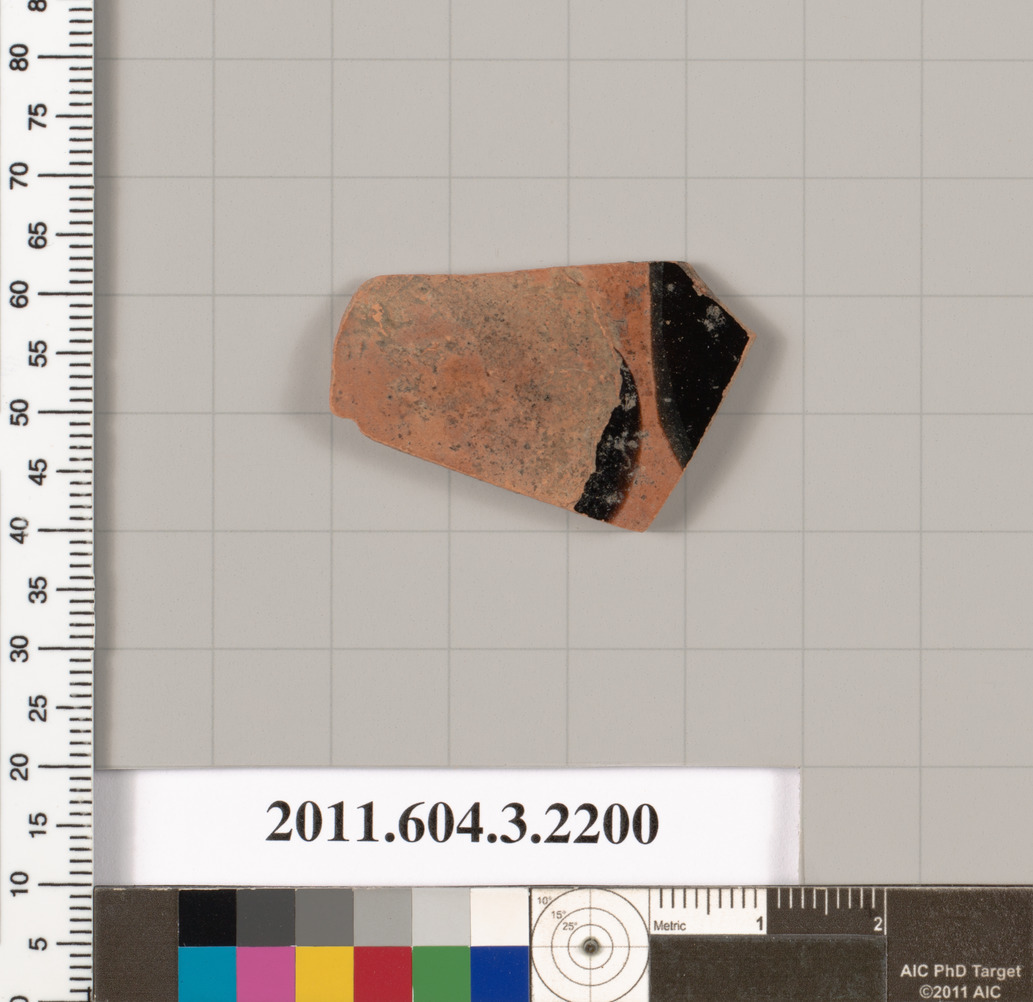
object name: kylix fragment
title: Terracotta fragment of a kylix (drinking cup)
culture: greek, attic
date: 600-401 BCE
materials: terracotta